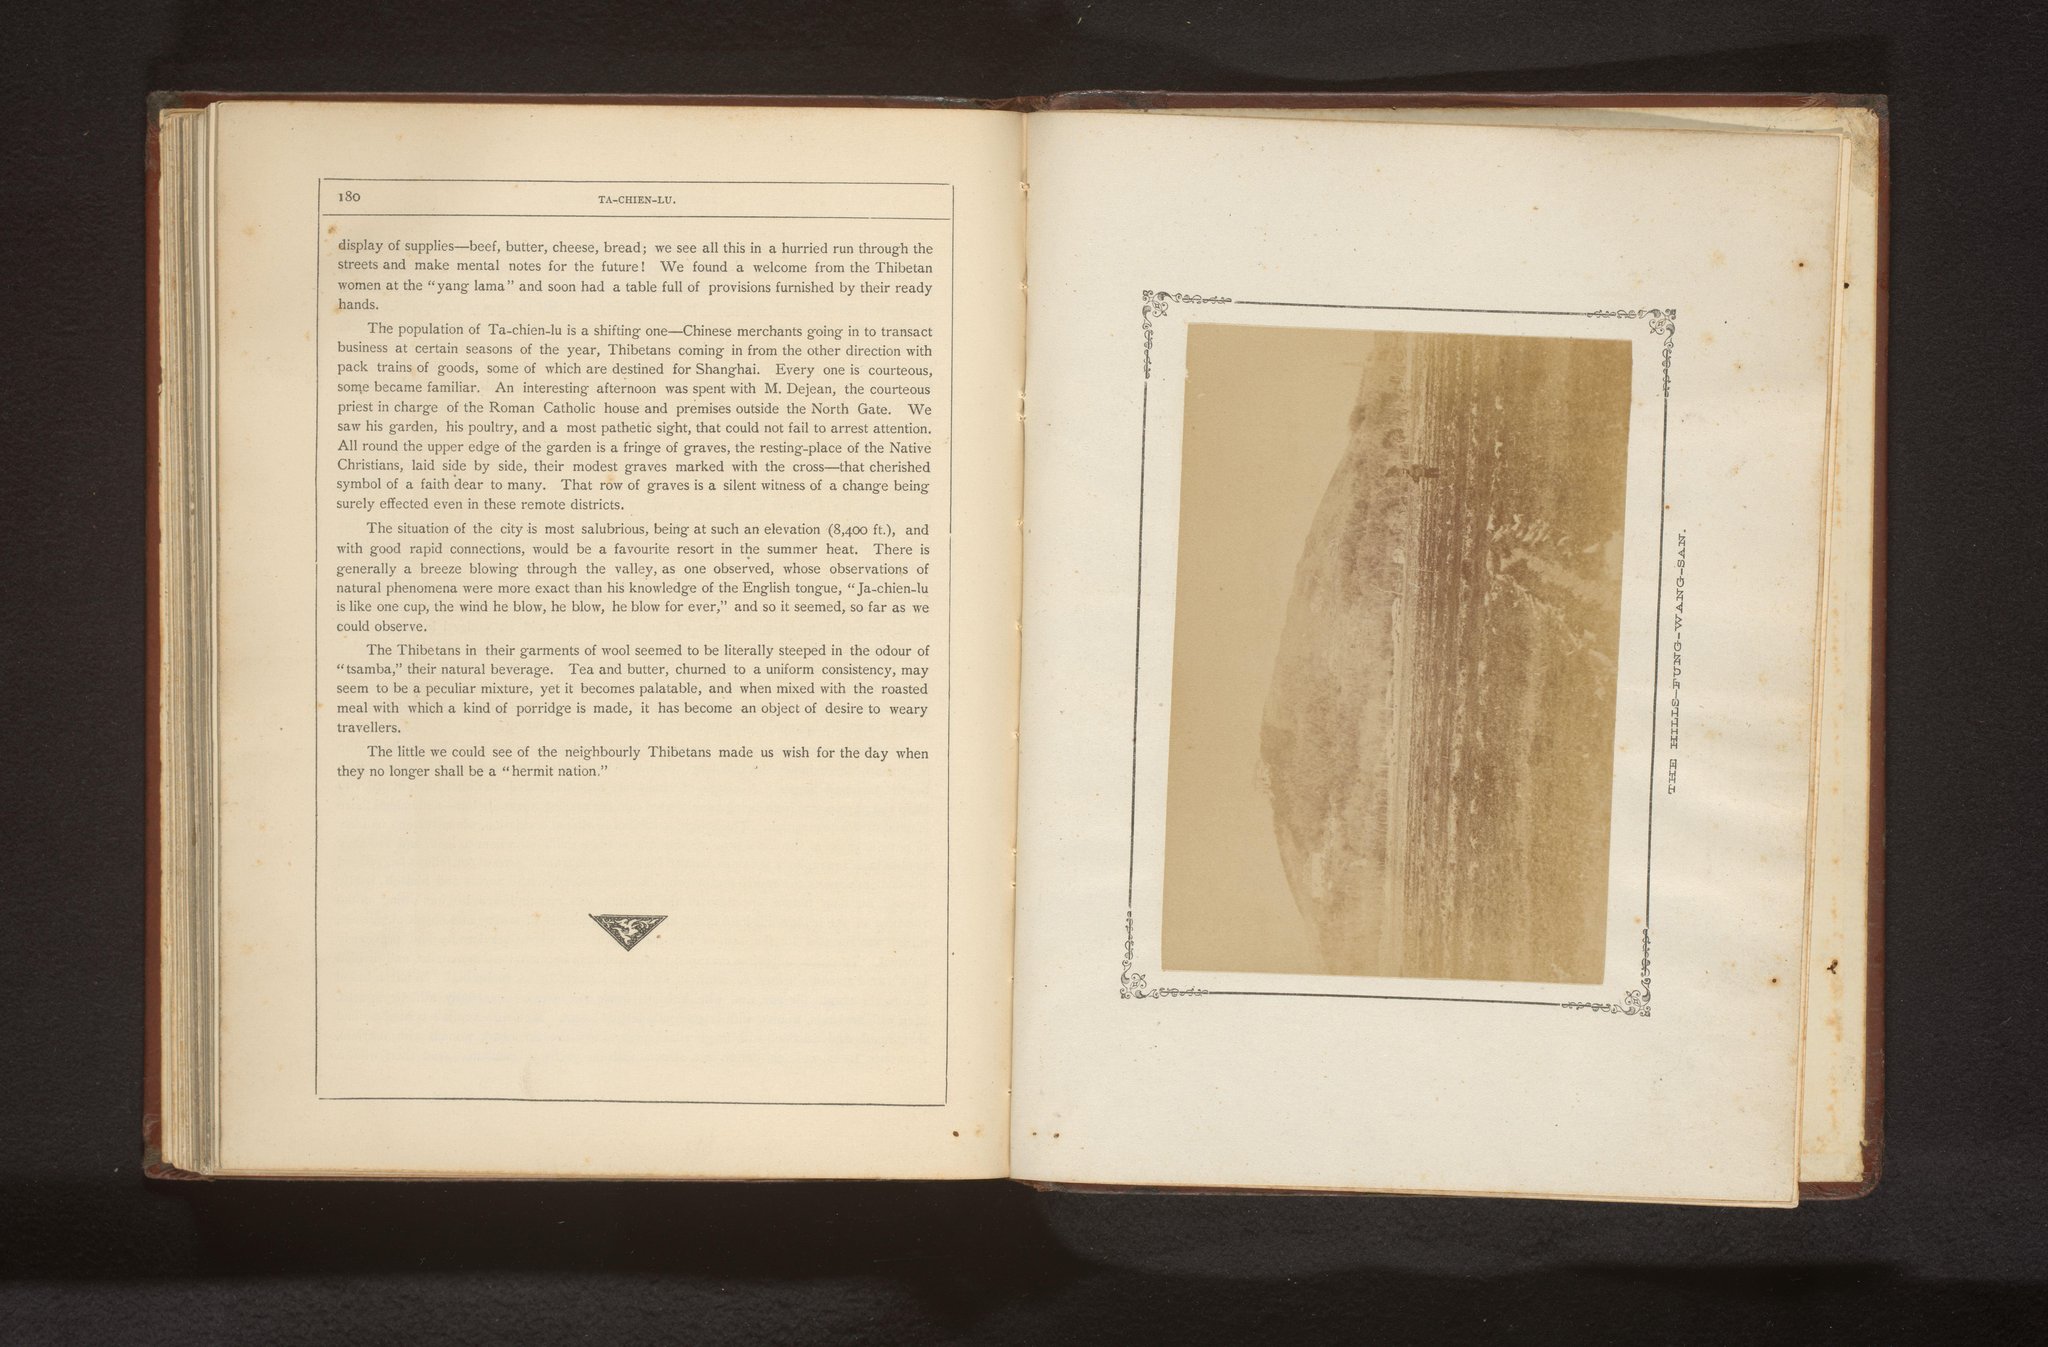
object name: page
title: The hills-Fung-Wang-San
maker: Anonymous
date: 1884-1894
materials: photographic support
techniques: albumen print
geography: china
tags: (high) hill, china